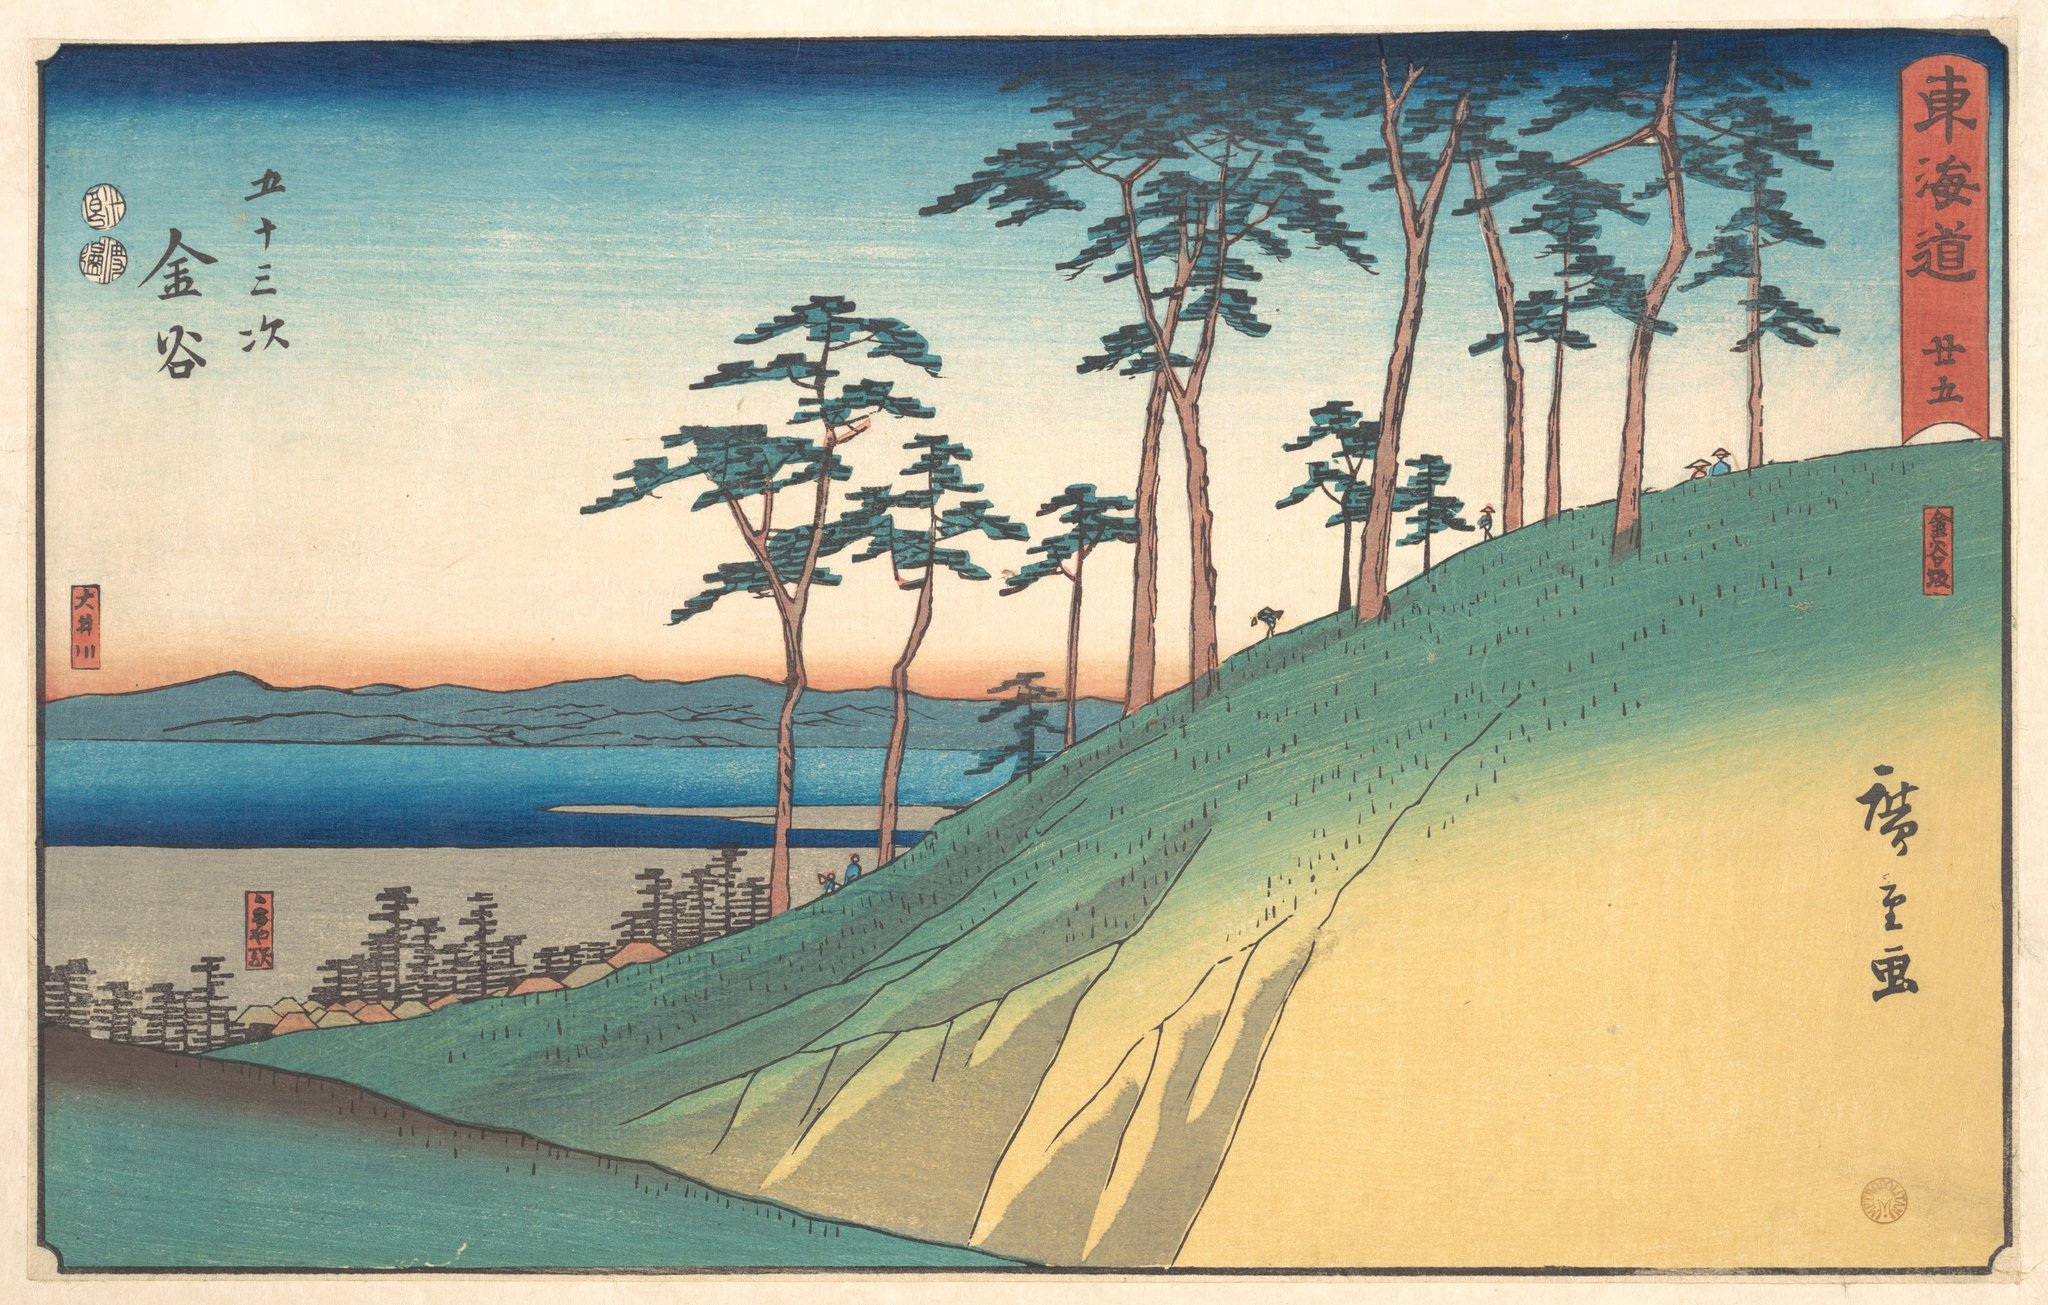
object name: print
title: Kanaya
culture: japanese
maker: utagawa hiroshige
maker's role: artist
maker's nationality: japanese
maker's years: 1797-1858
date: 1840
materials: ink, paper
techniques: woodblock print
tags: landscapes,trees